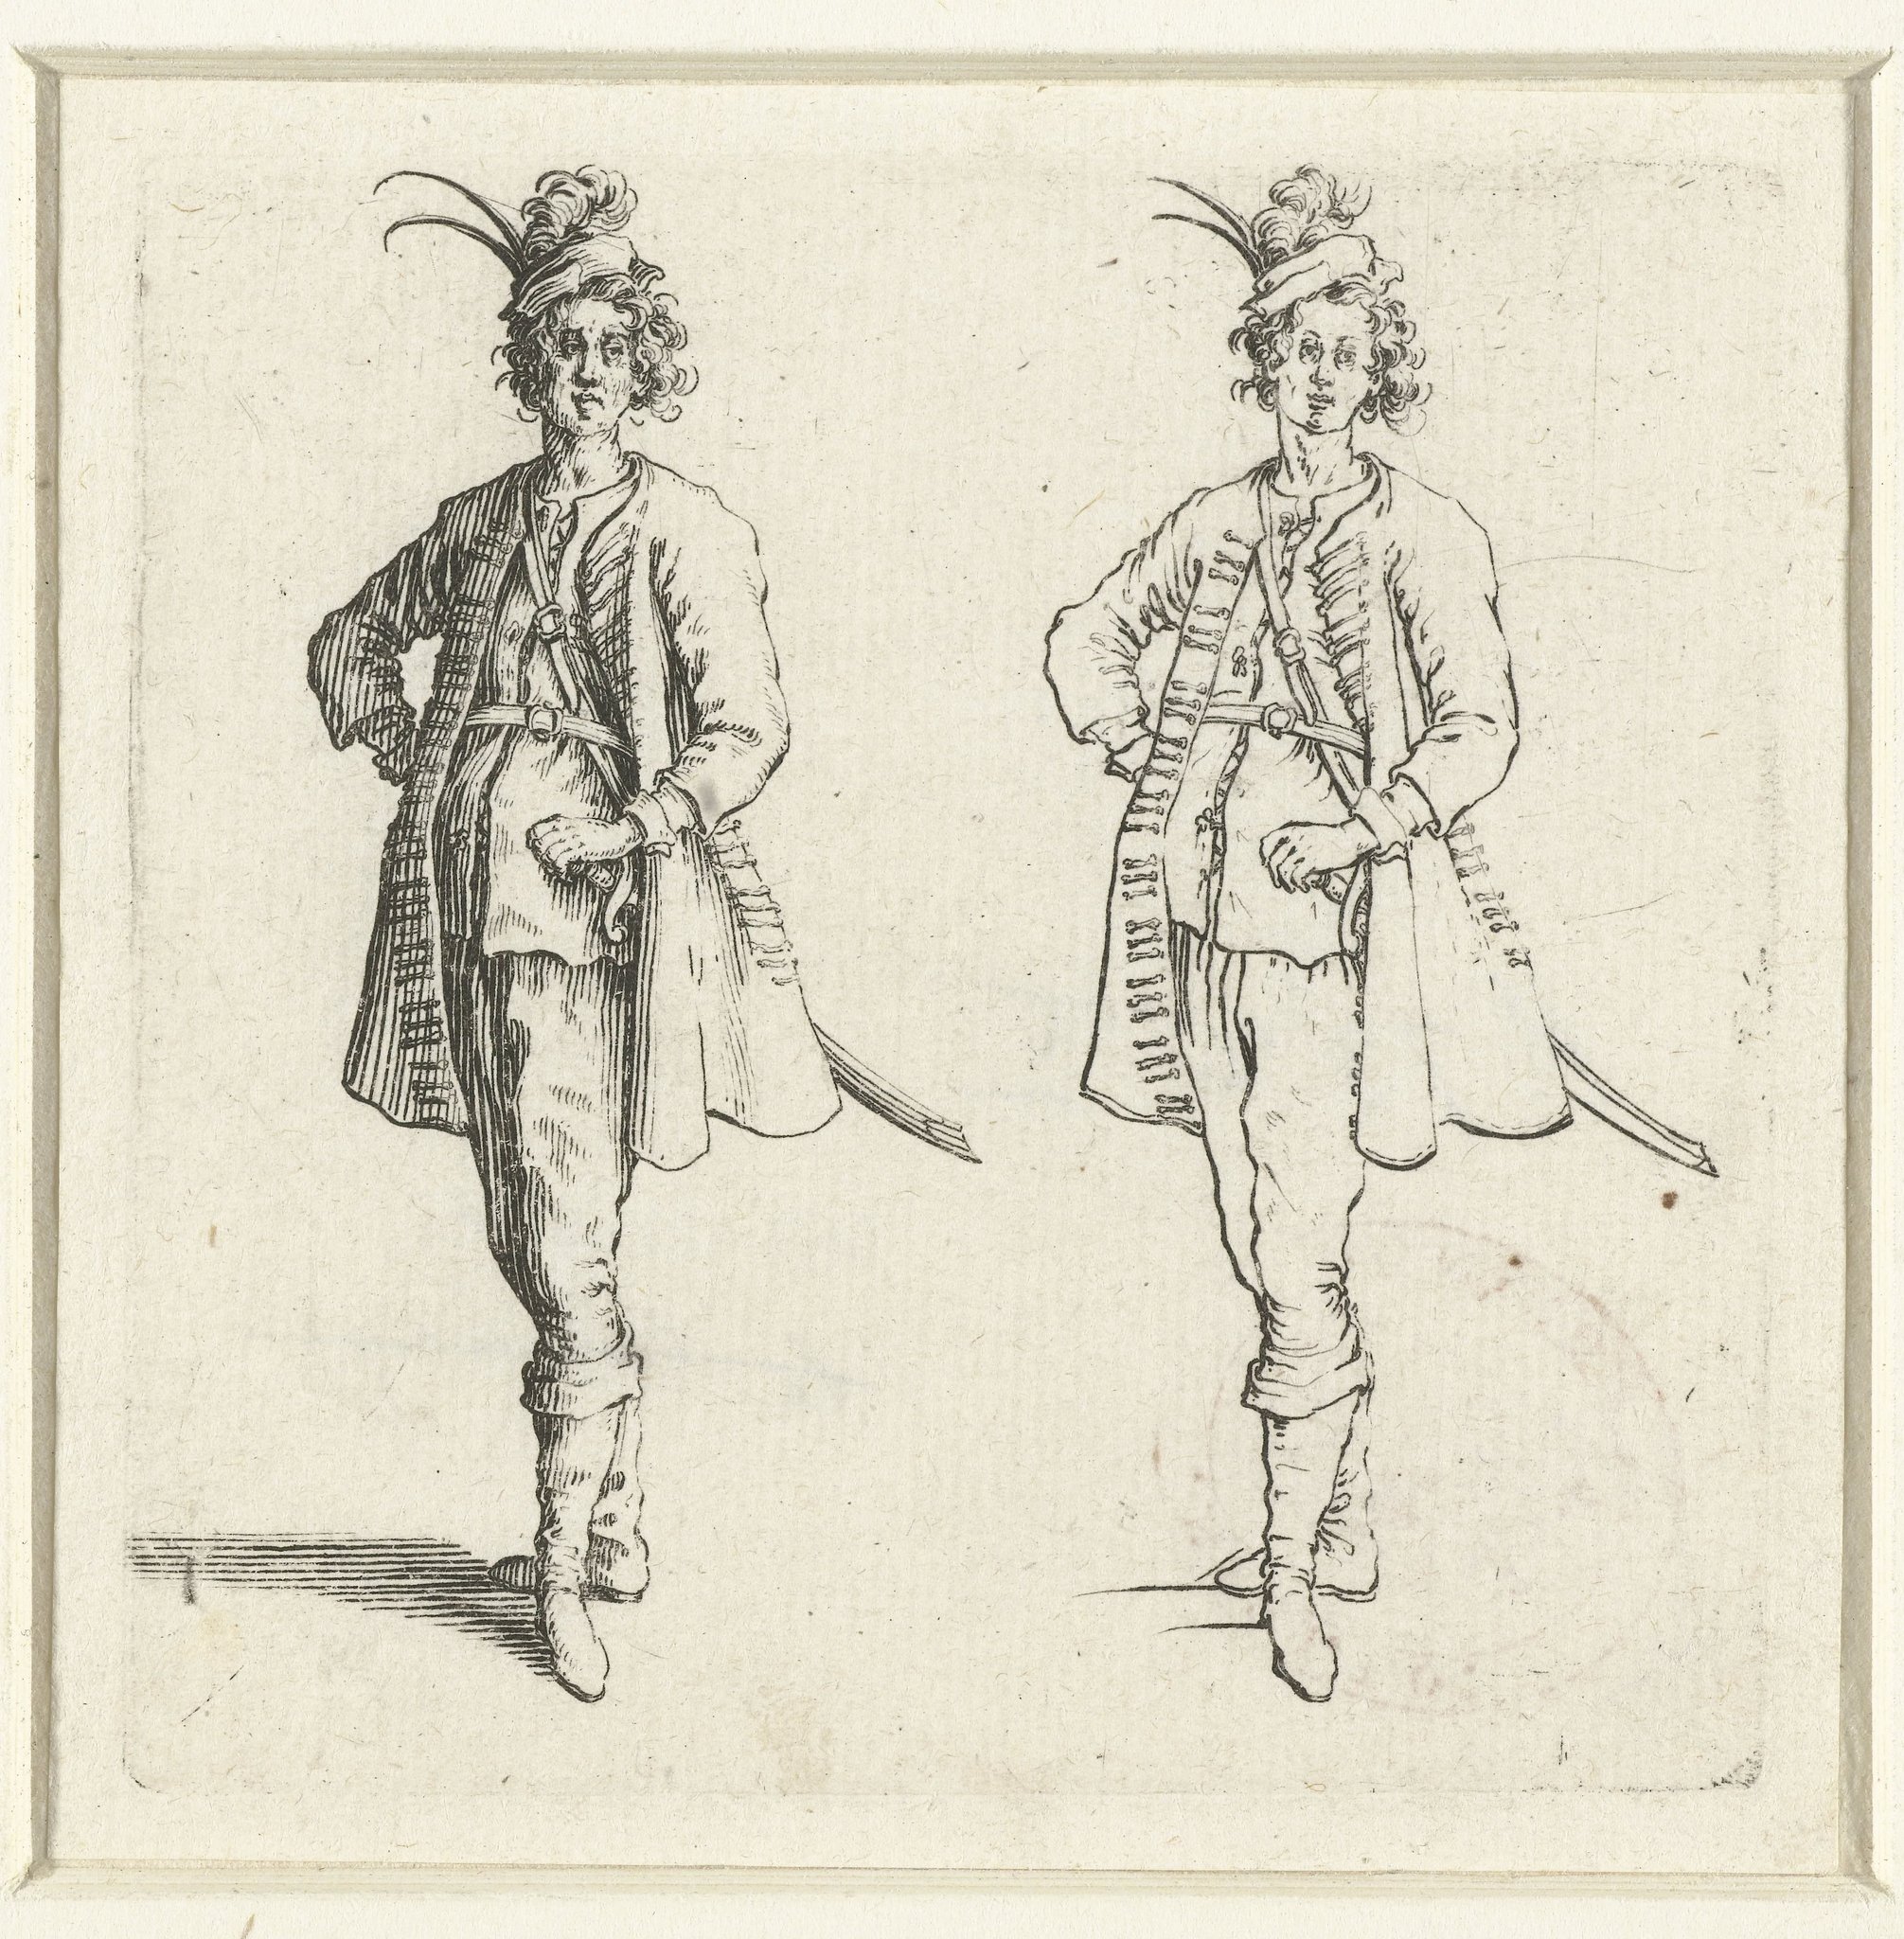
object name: print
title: Varie figure di Jacopo Callot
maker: jacques callot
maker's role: draughtsman, print maker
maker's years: 1592-1635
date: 1621-1624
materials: paper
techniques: etching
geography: nancy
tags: private soldier, head-gear: hat (+ men's clothes)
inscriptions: collector's mark: Lugt 240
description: Een soldaat met een gepluimd hoedje op het hoofd, de rechterhand in de zij, de linkerhand op het gevest van zijn zwaard, van voren gezien, tweemaal afgebeeld: rechts als lijnfiguur, links meer uitgewerkt met schaduwpartijen. Deze prent is onderdeel van een serie van 16 prenten (15 volgens Lieure; 17 resp. 16 incl. titelprent) met mannen en vrouwen in diverse houdingen. Mogelijk zijn deze prenten bedoeld geweest als tekenvoorbeelden.